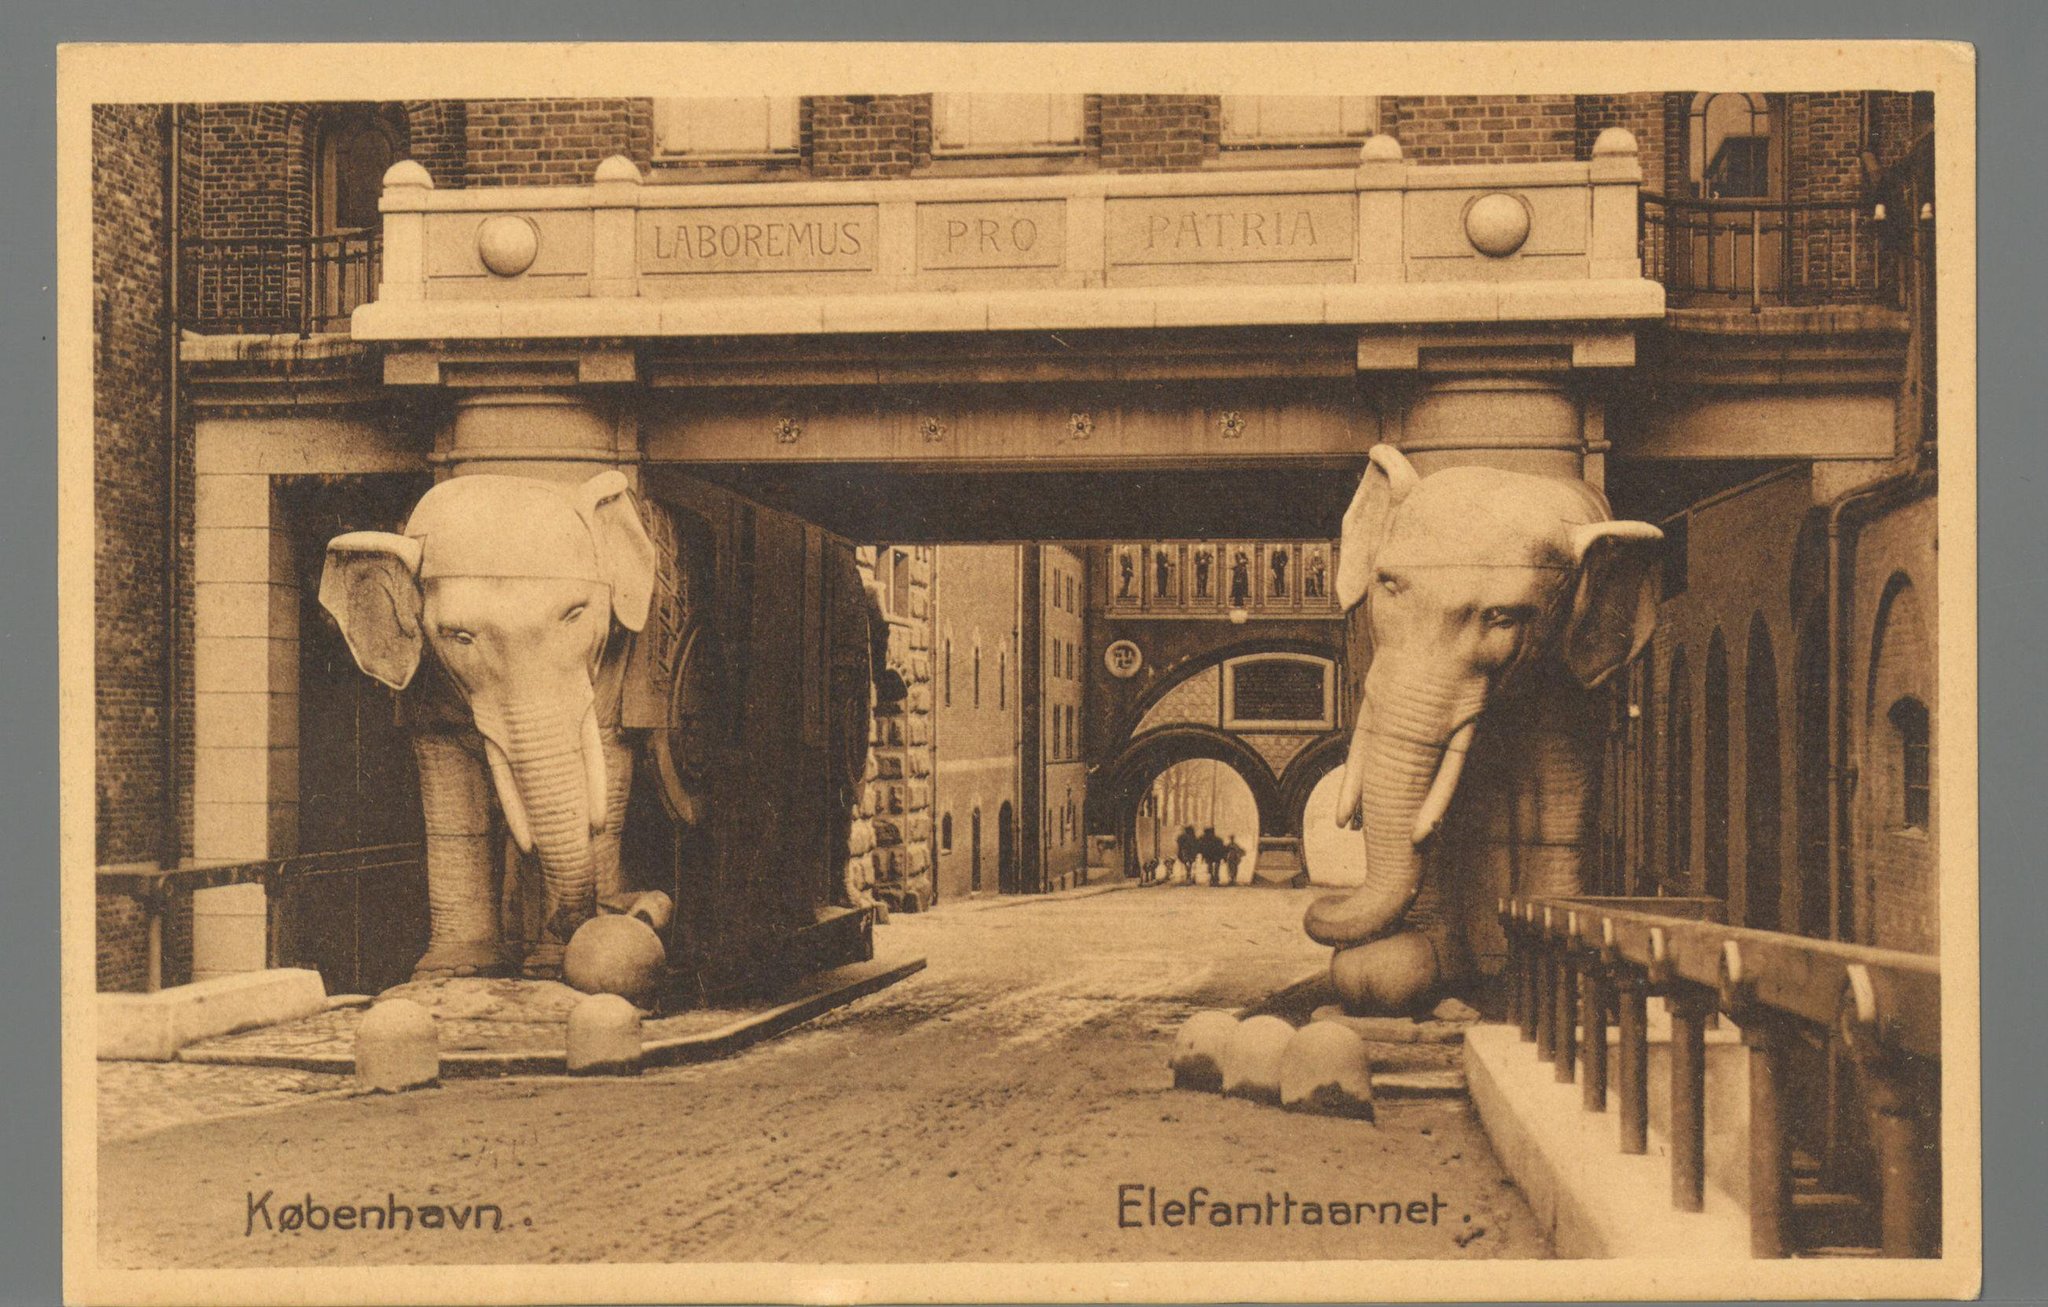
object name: ansichtkaart, prentbriefkaart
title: Köbenhavn. Elefanttaarnet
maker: Anonymous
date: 1906-1920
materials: cardboard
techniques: photograph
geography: copenhagen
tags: passage (+ city(-scape) with figures, staffage), sculpture, copenhagen (city)